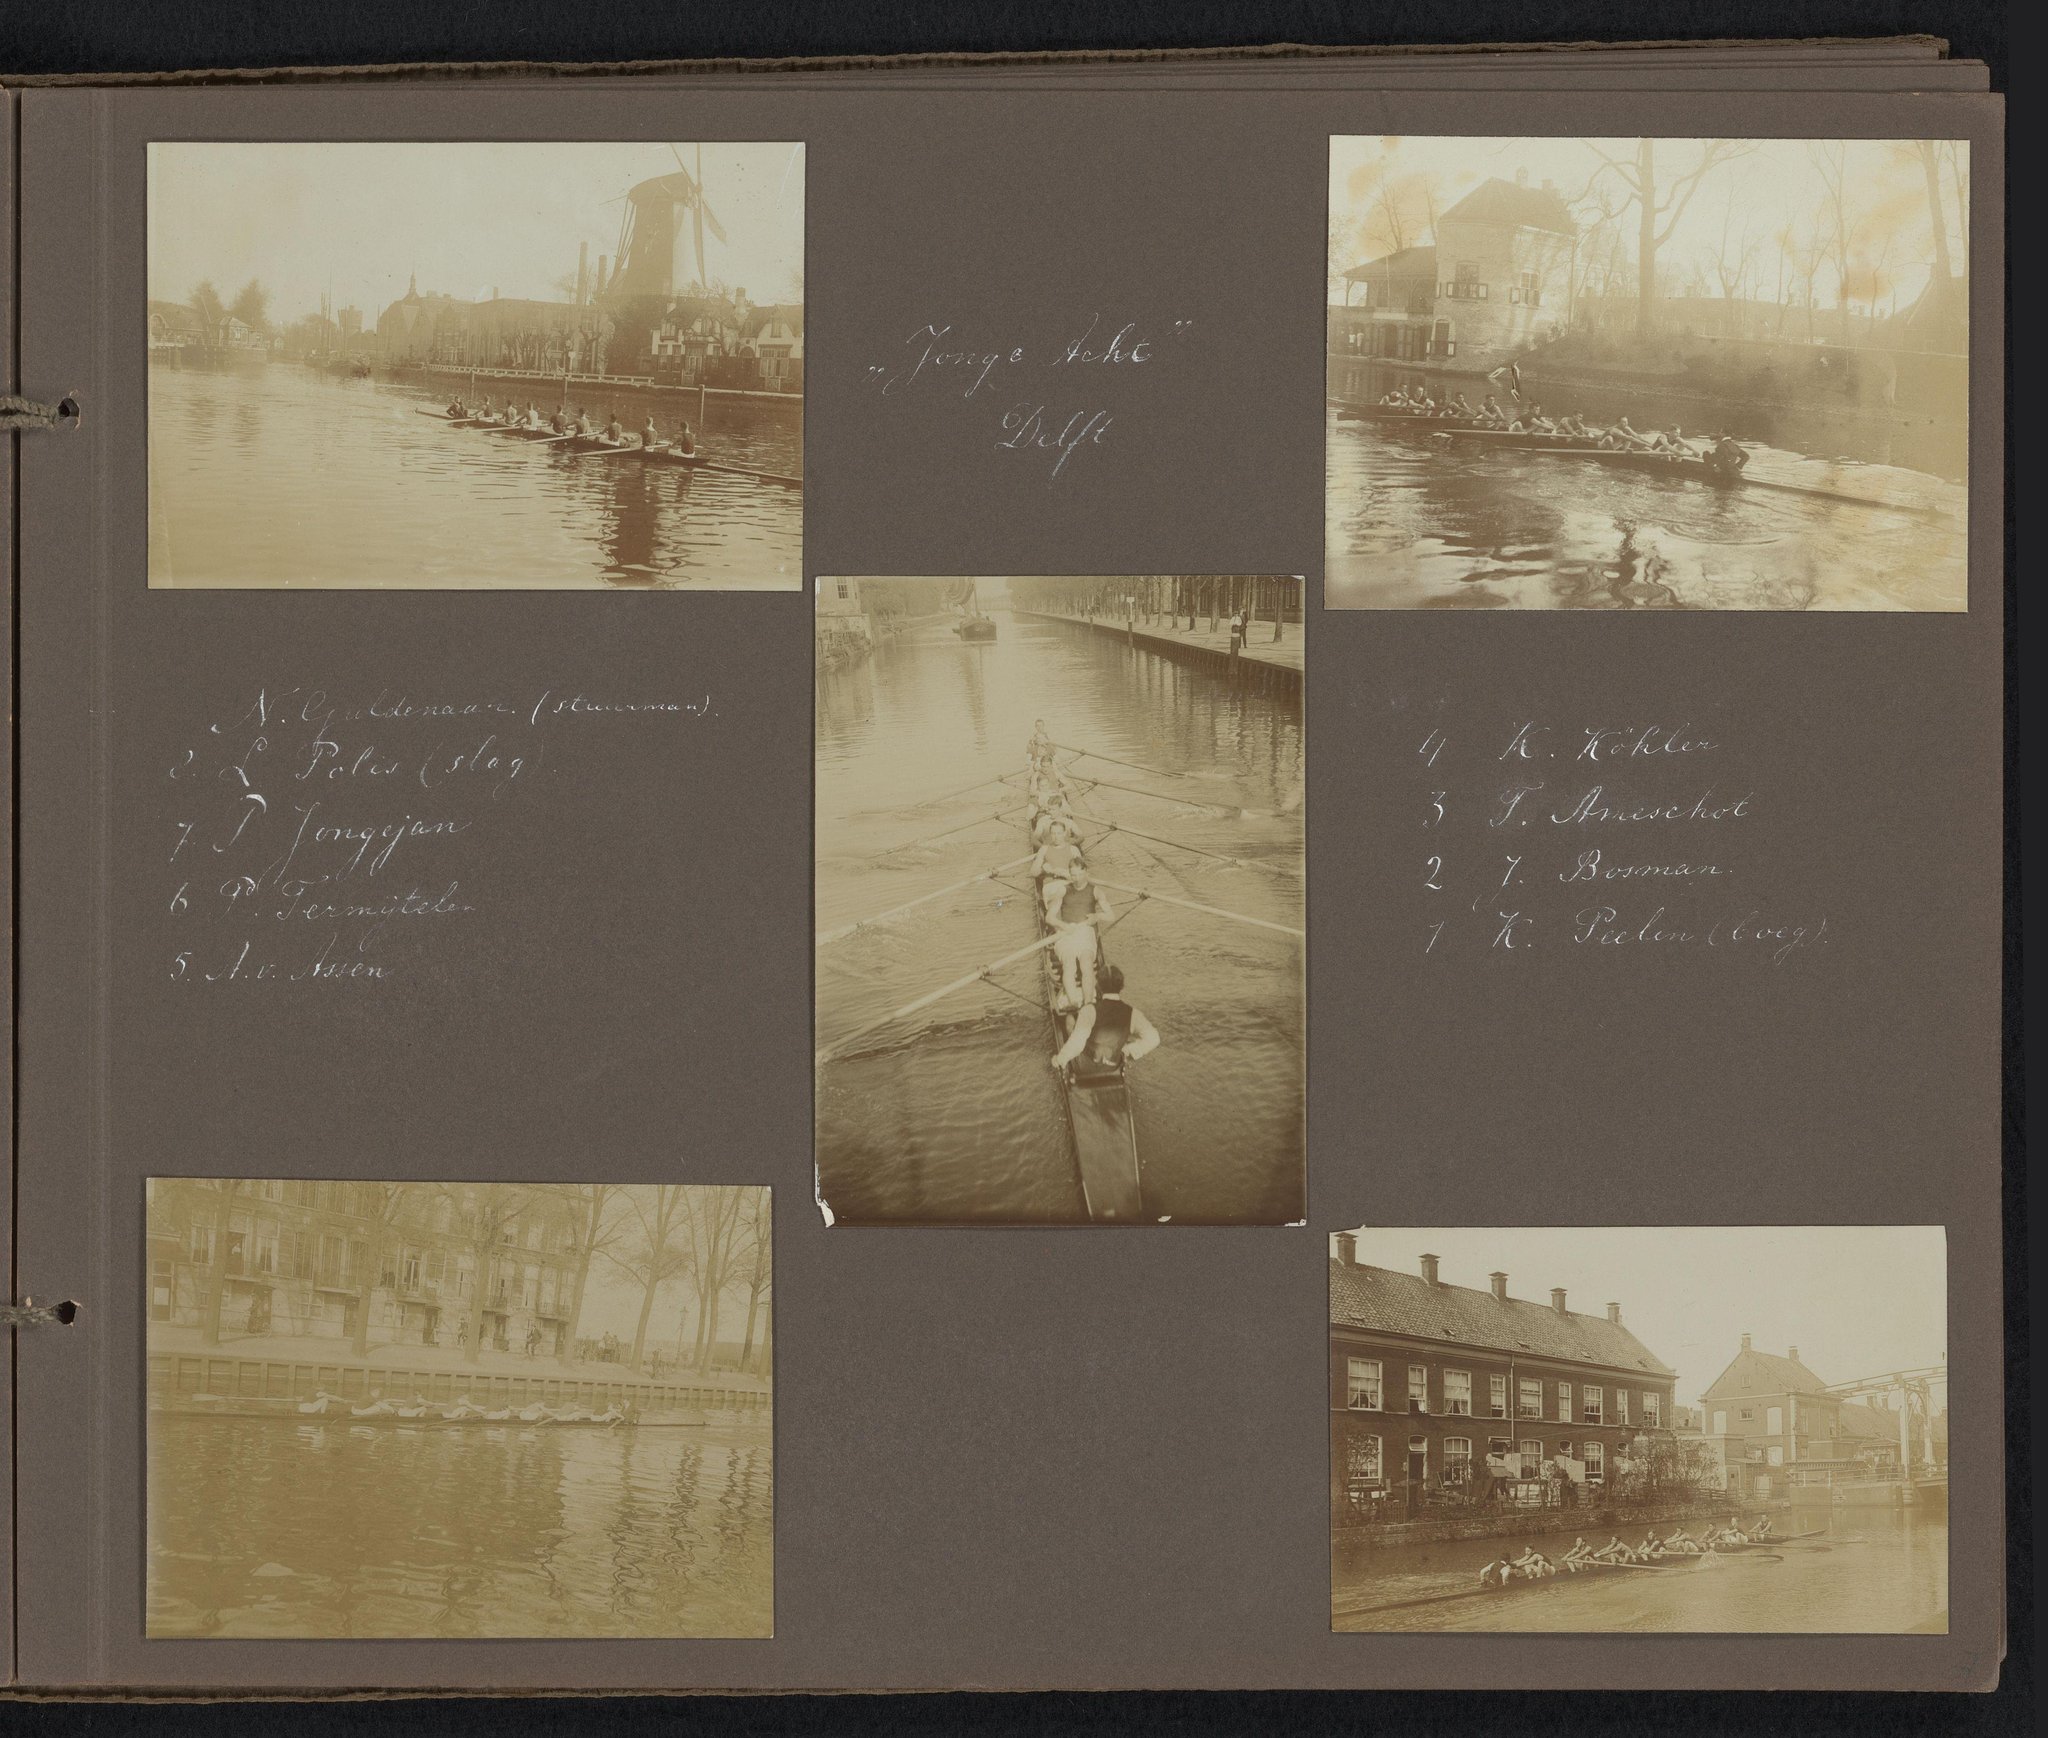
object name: album leaf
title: Vijf foto's van roeiploeg Jonge Acht in actie te Delft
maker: Anonymous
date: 1915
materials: paper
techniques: gelatin silver print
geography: delft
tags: rowing facing backward, pulling, delft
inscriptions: caption: ‘"Jonge Acht"/ Delft/ N. Guldeman (stuurman)/ 8. L. Polis (slag)./ 7. P. Jongejan/ 6. P. [K] Termijtelen/ 5. A. v. Assen/ 4. K. Köhler/ 3. A. Ameschot/ 2. J. Bosman/ 1. K. Peelen (boeg)’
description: Deze foto's maken deel uit van een album.